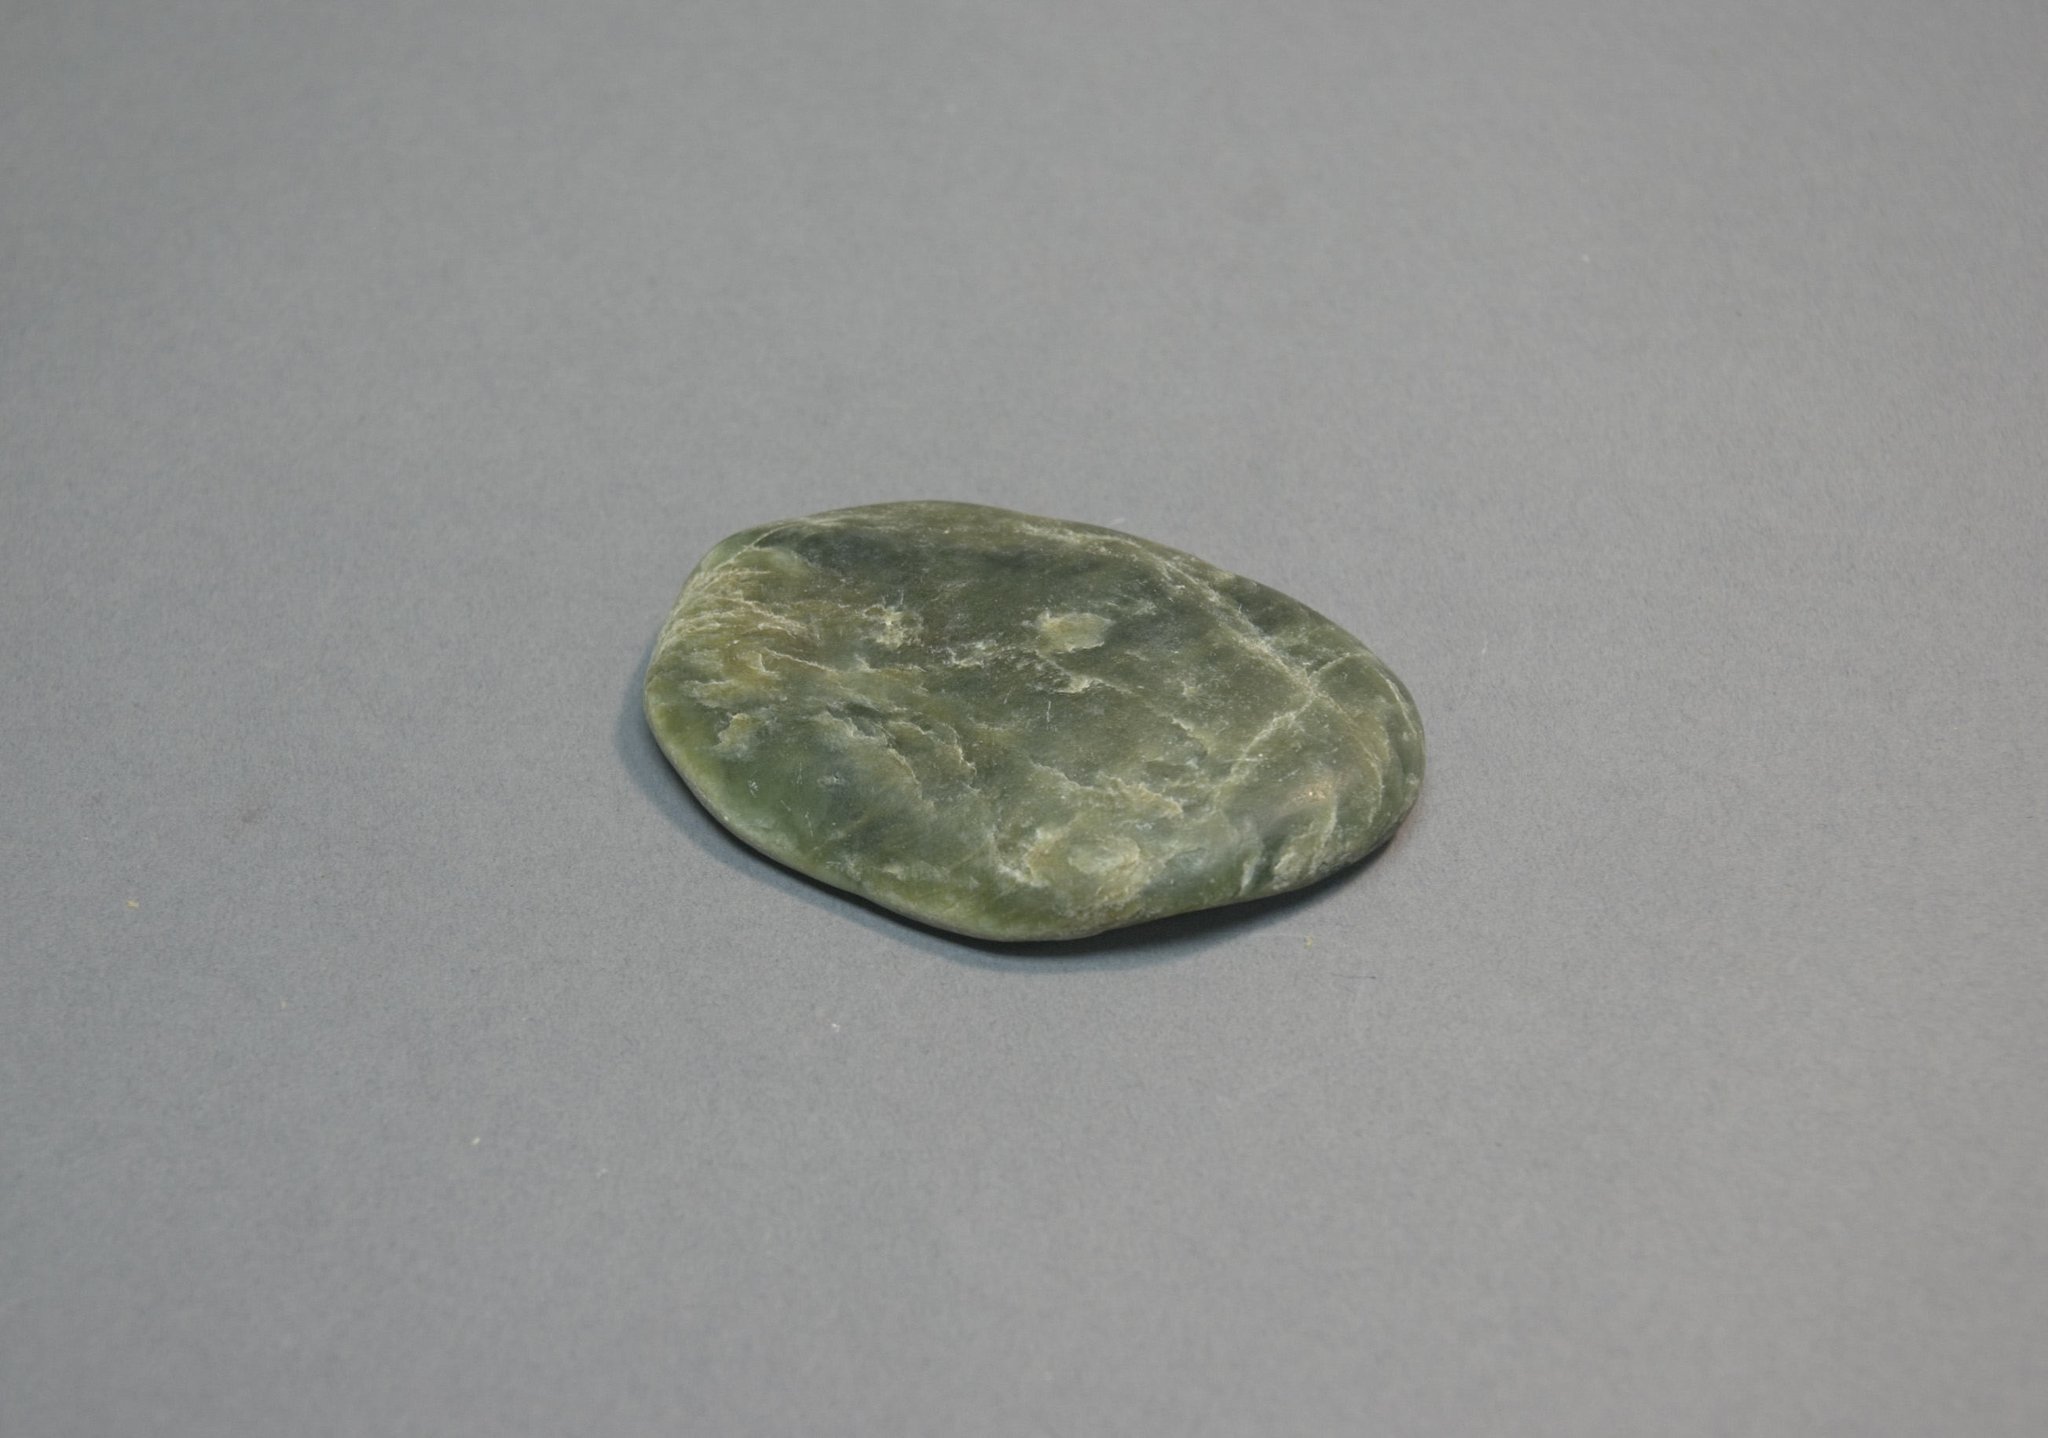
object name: jade carving material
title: Nephrite Pebble from New Zealand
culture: chinese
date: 1901-2000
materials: jade